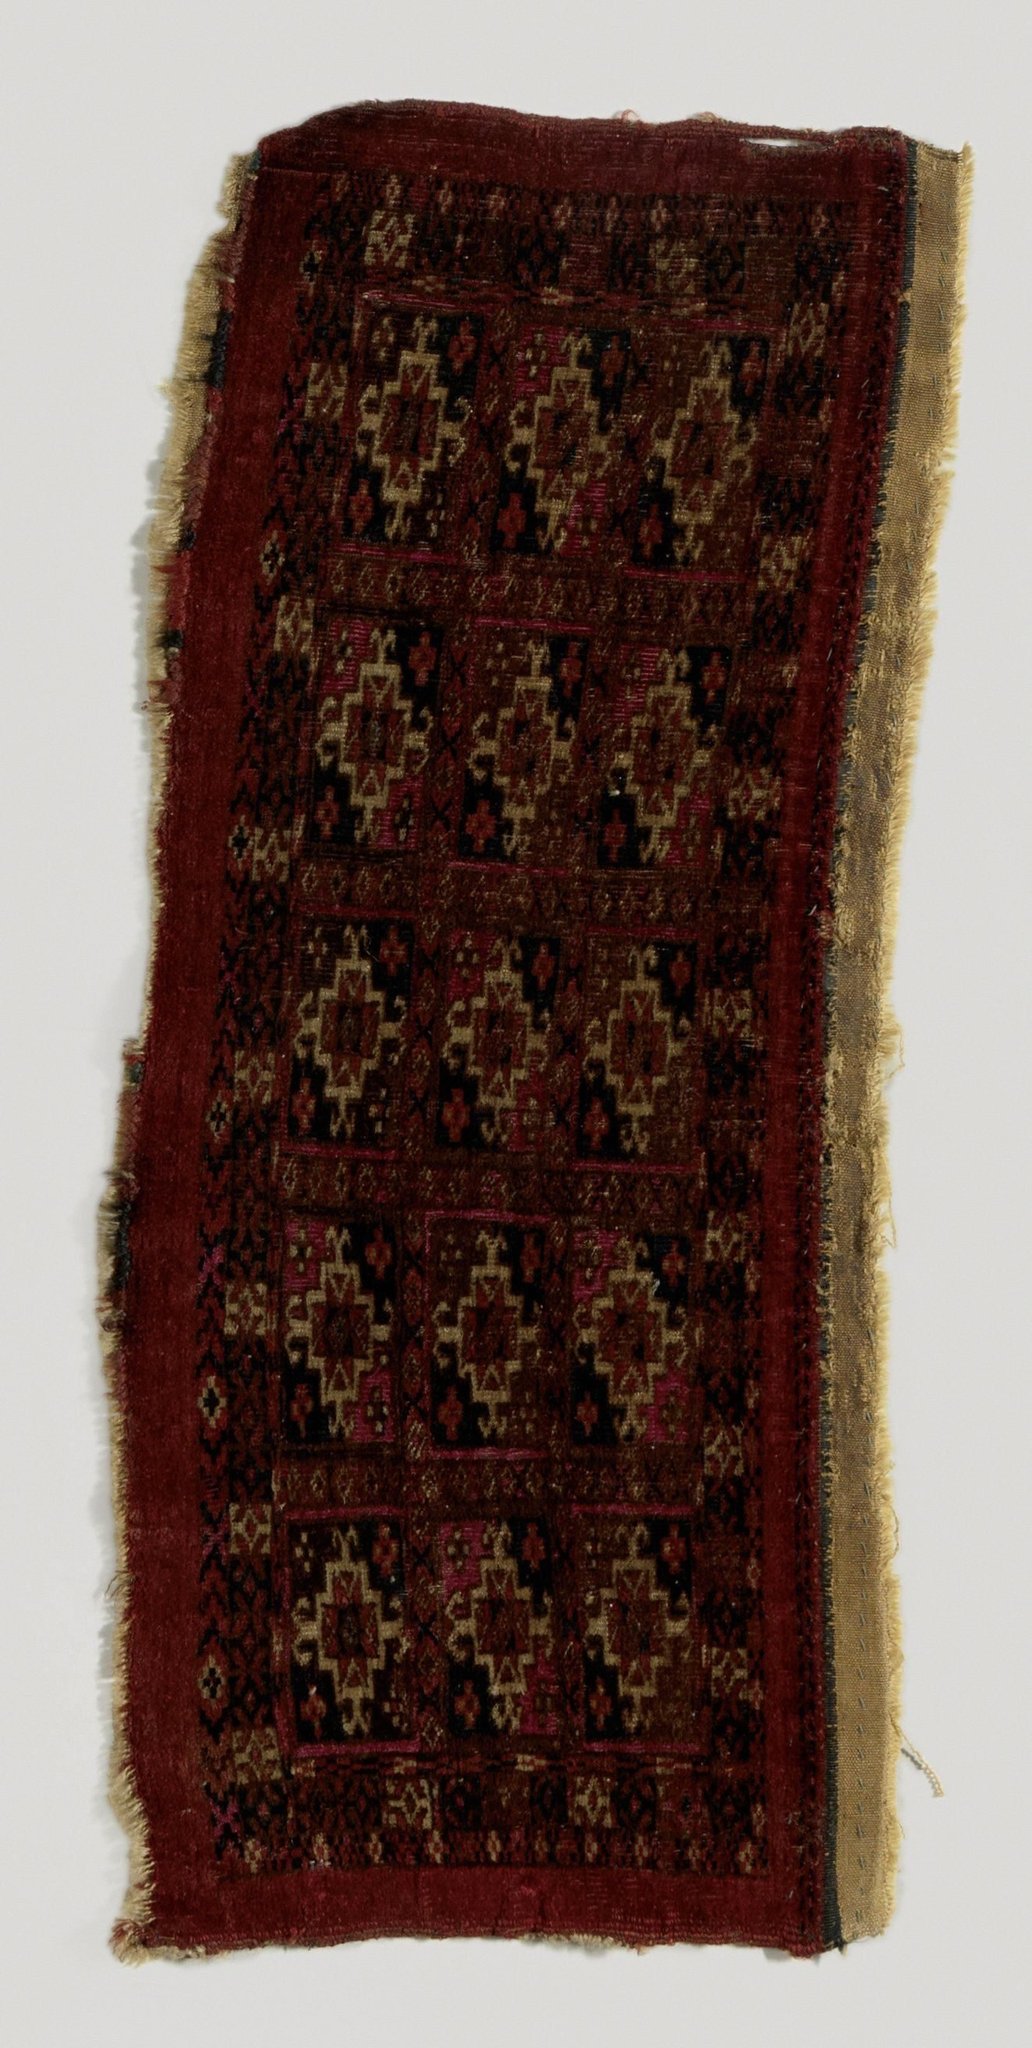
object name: oriental rug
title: Tentzakvoorblad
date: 1850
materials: silk, wool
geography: turkestan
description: Tentzakvoorblad, in klein model, Torba, van wol en enige knopen van zijde in cerise. Deze torba is versierd met het aina-gochak-motief binnen rechthoekige compartimenten.